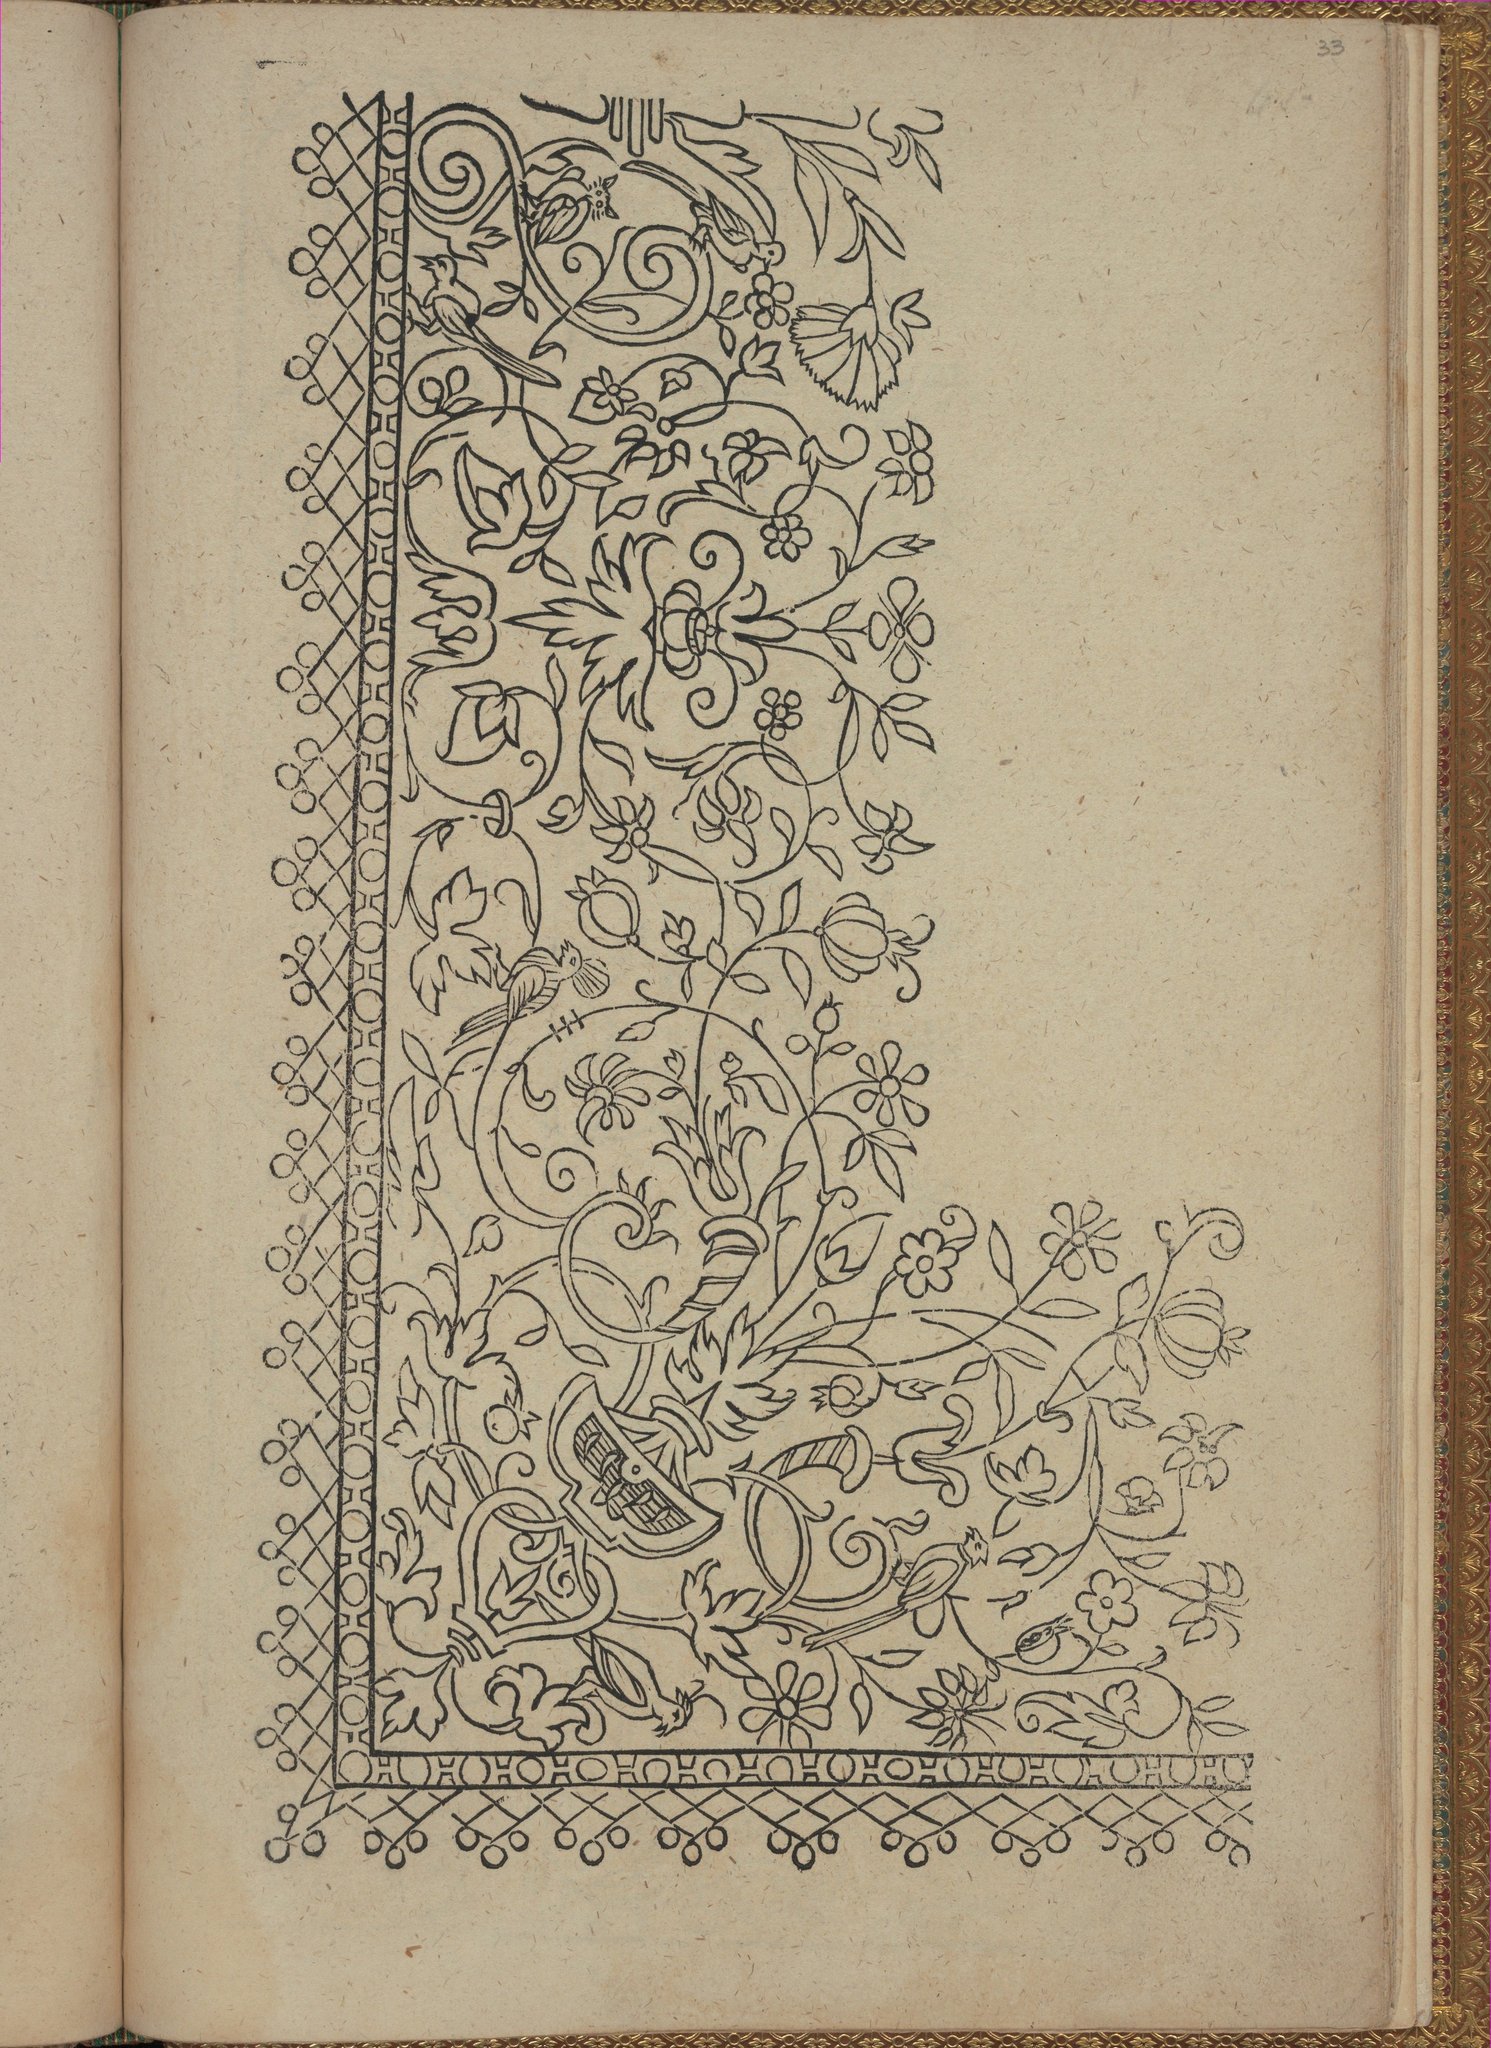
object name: book print ornament architecture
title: New Modelbüch (Page 33r)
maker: andreas bretschneider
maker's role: designer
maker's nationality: german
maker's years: 1573-1645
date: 1615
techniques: woodcut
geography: germany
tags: flowers